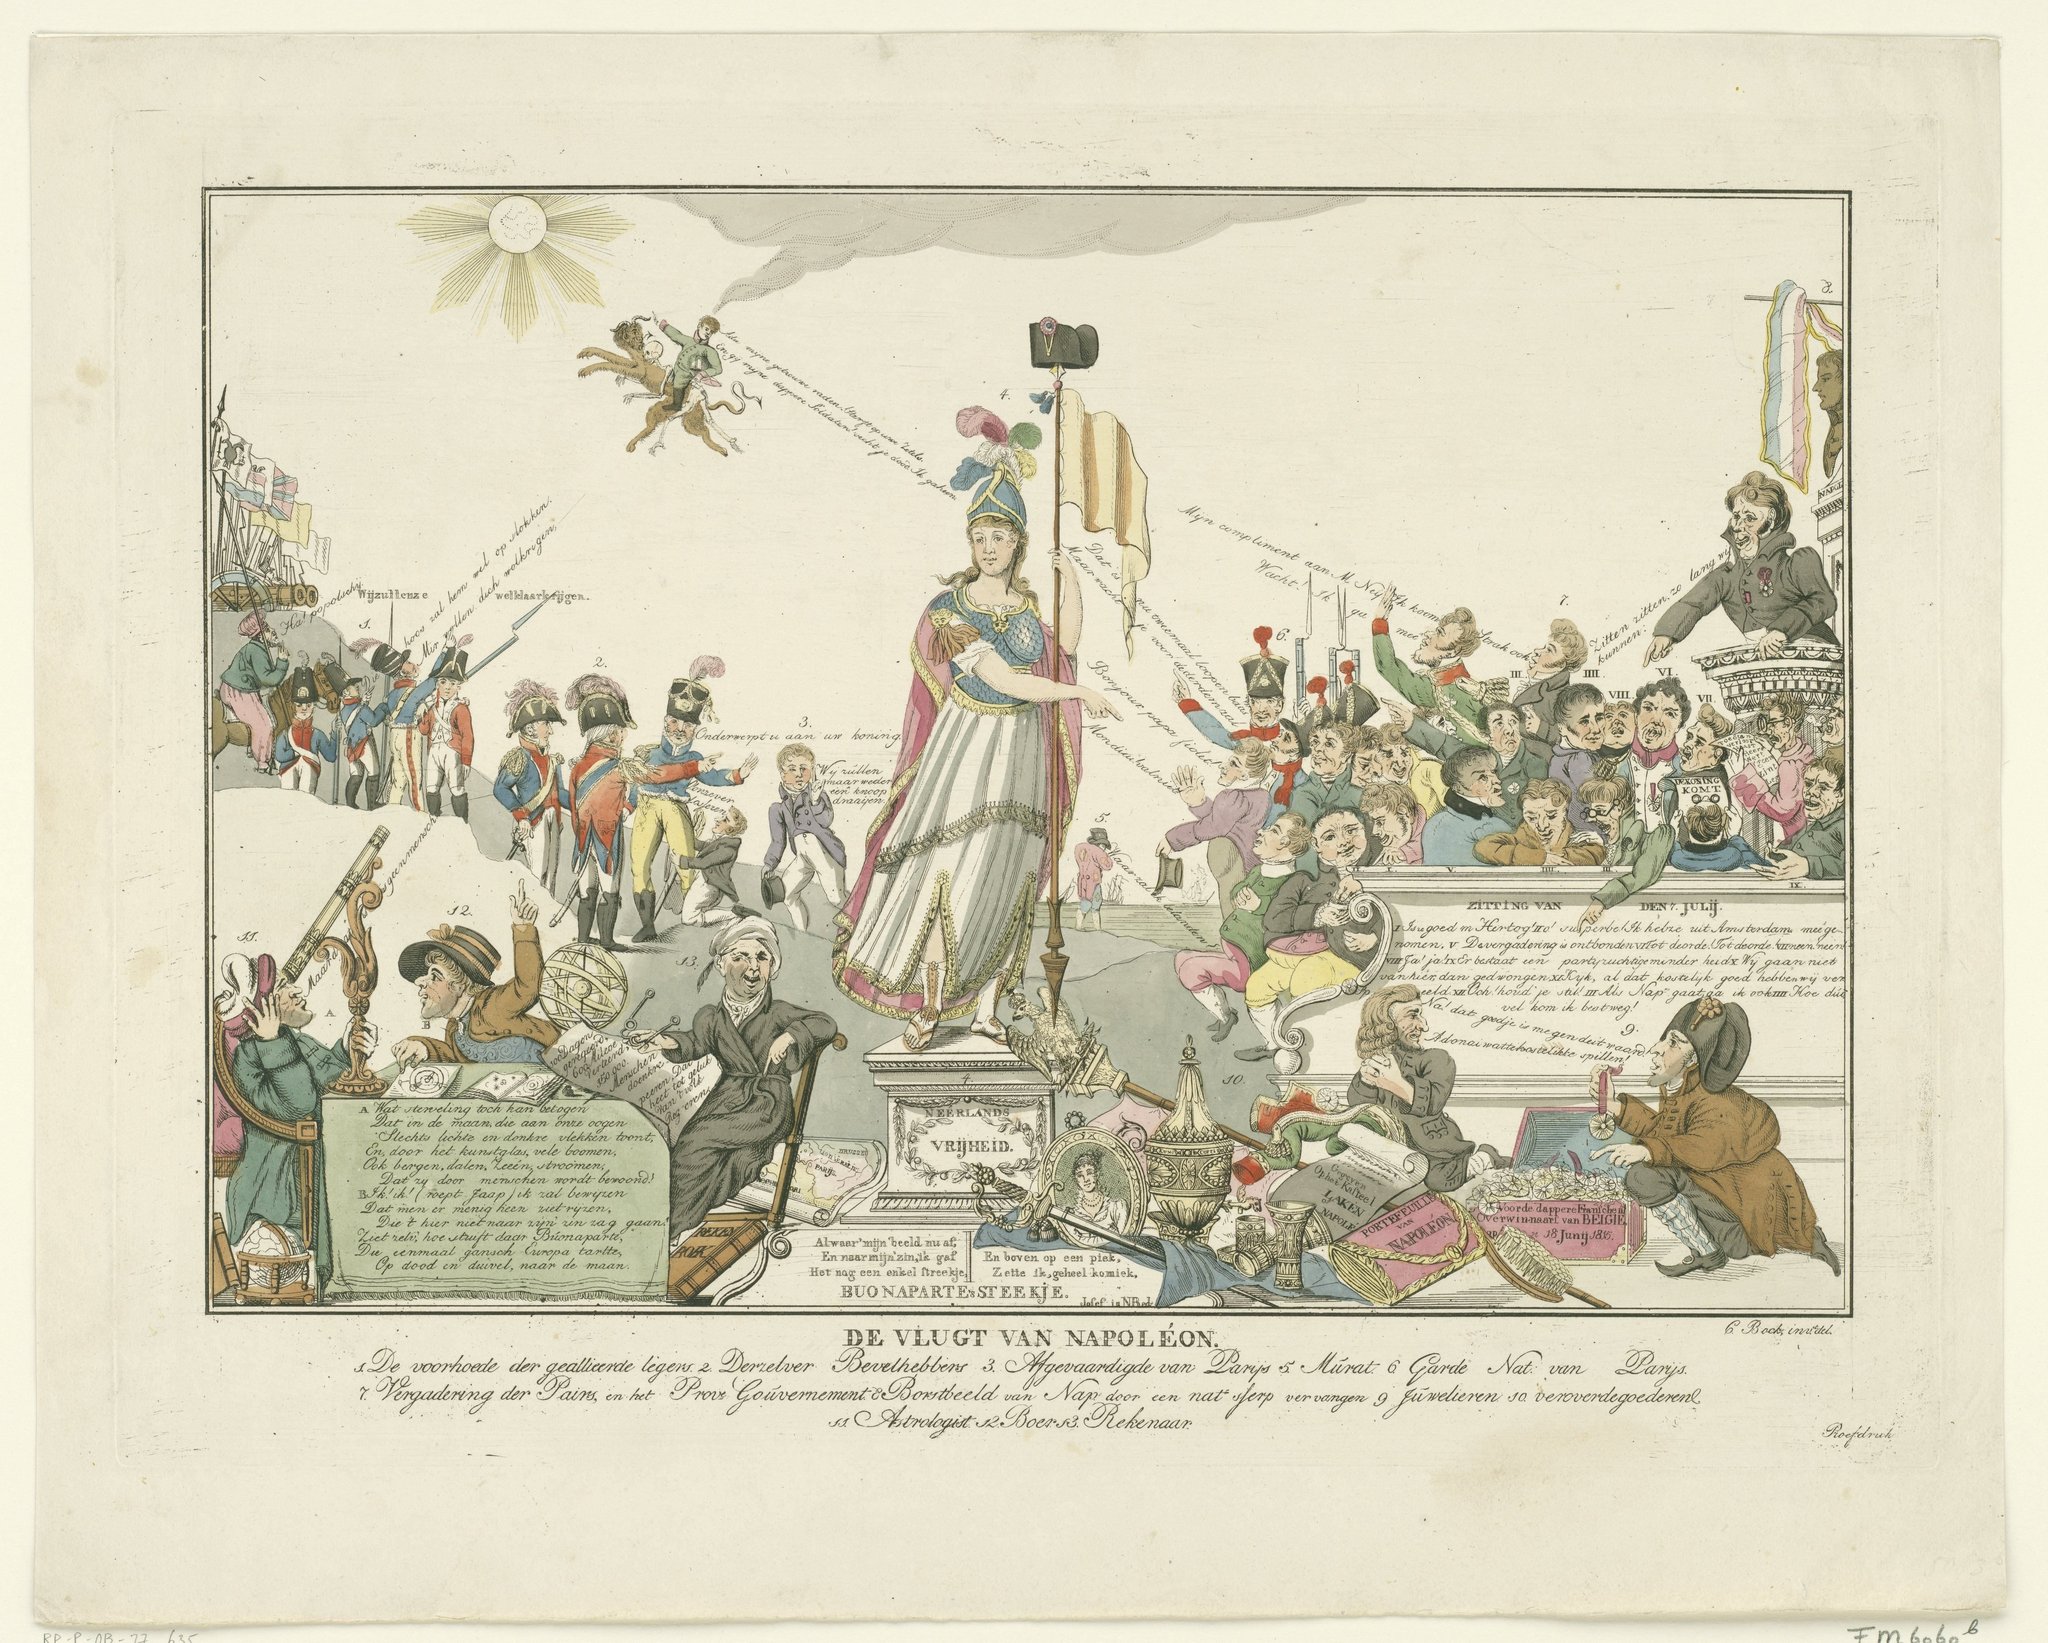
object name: print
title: Vlucht van Napoleon, 1815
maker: christoph wilhelm bock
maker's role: print maker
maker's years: 1755-1836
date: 1815-1820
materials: paper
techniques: etching, hand coloring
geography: netherlands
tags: walmer castle, arthur wellesley of wellington, napoleon i (emperor of the french), religious and magic concepts, occupations, fashions, realities, general ideas ~ judaism and jewry, personifications of countries, nations, states, districts, etc., telescope, netherlands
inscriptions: collector's mark: Lugt 2228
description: Spotprent op de vlucht van Napoleon na de Franse nederlaag in de Slag bij Waterloo op 18 juni 1815. Centraal de Nederlandse Maagd met de steek van Napoleon op de vrijheidslans. Links rijdt Napoleon op de Duivel en de Dood naar de maan. Linksvoor bekijkt een astroloog dit schouwspel door een verrekijker, naast hem een boer en een boekhouder die de kosten van Napoleons honderd dagen uitrekent. Rechtsvoor de op het kasteel van Laken nagelaten spullen van Napoleon, hierbij een Joodse opkoper of taxateur. Rechts achter chaos in het Franse parlement, linksachter de legers en aanvoerders van de bondgenoten. Met meerdere opschriften in de voorstelling, in het onderschrift de legenda 1-13.